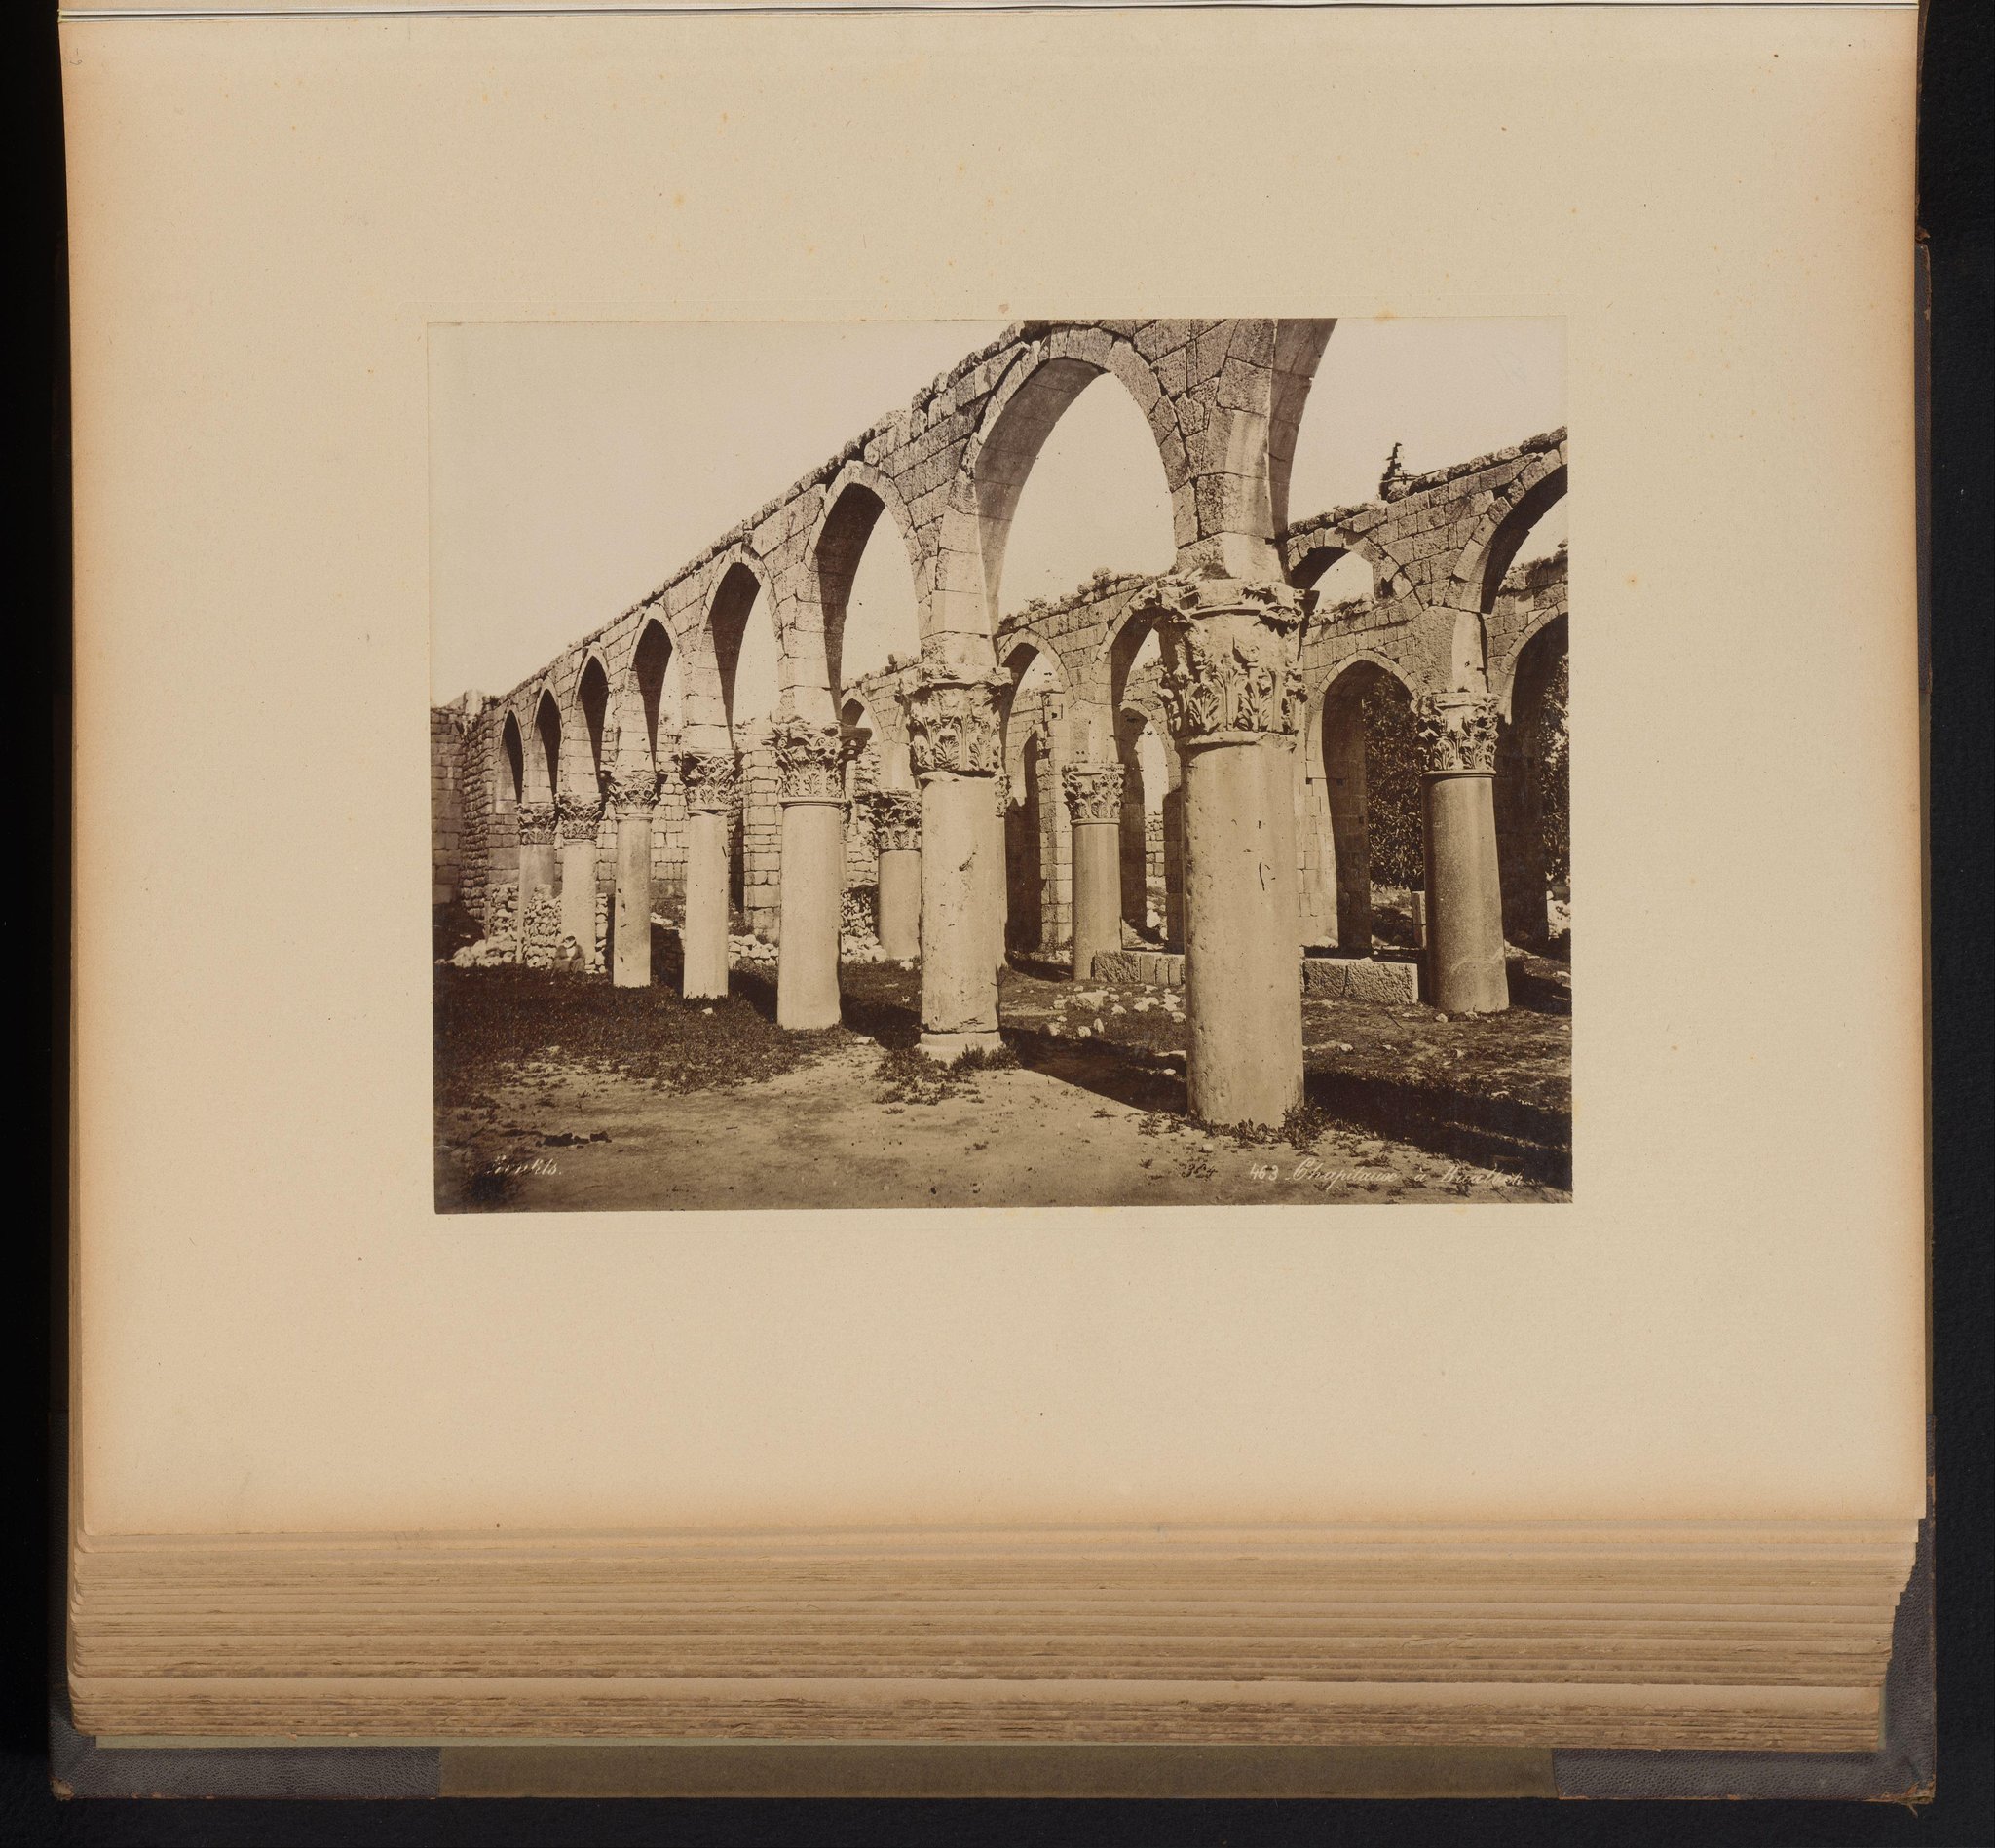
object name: photograph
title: Zuilengalerij in Baalbek, Libanon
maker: félix bonfils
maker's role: fotograaf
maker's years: 1831-1885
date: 1867-1885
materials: paper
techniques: albumen print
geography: baalbek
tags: landscape with ruins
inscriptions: number: ‘463’